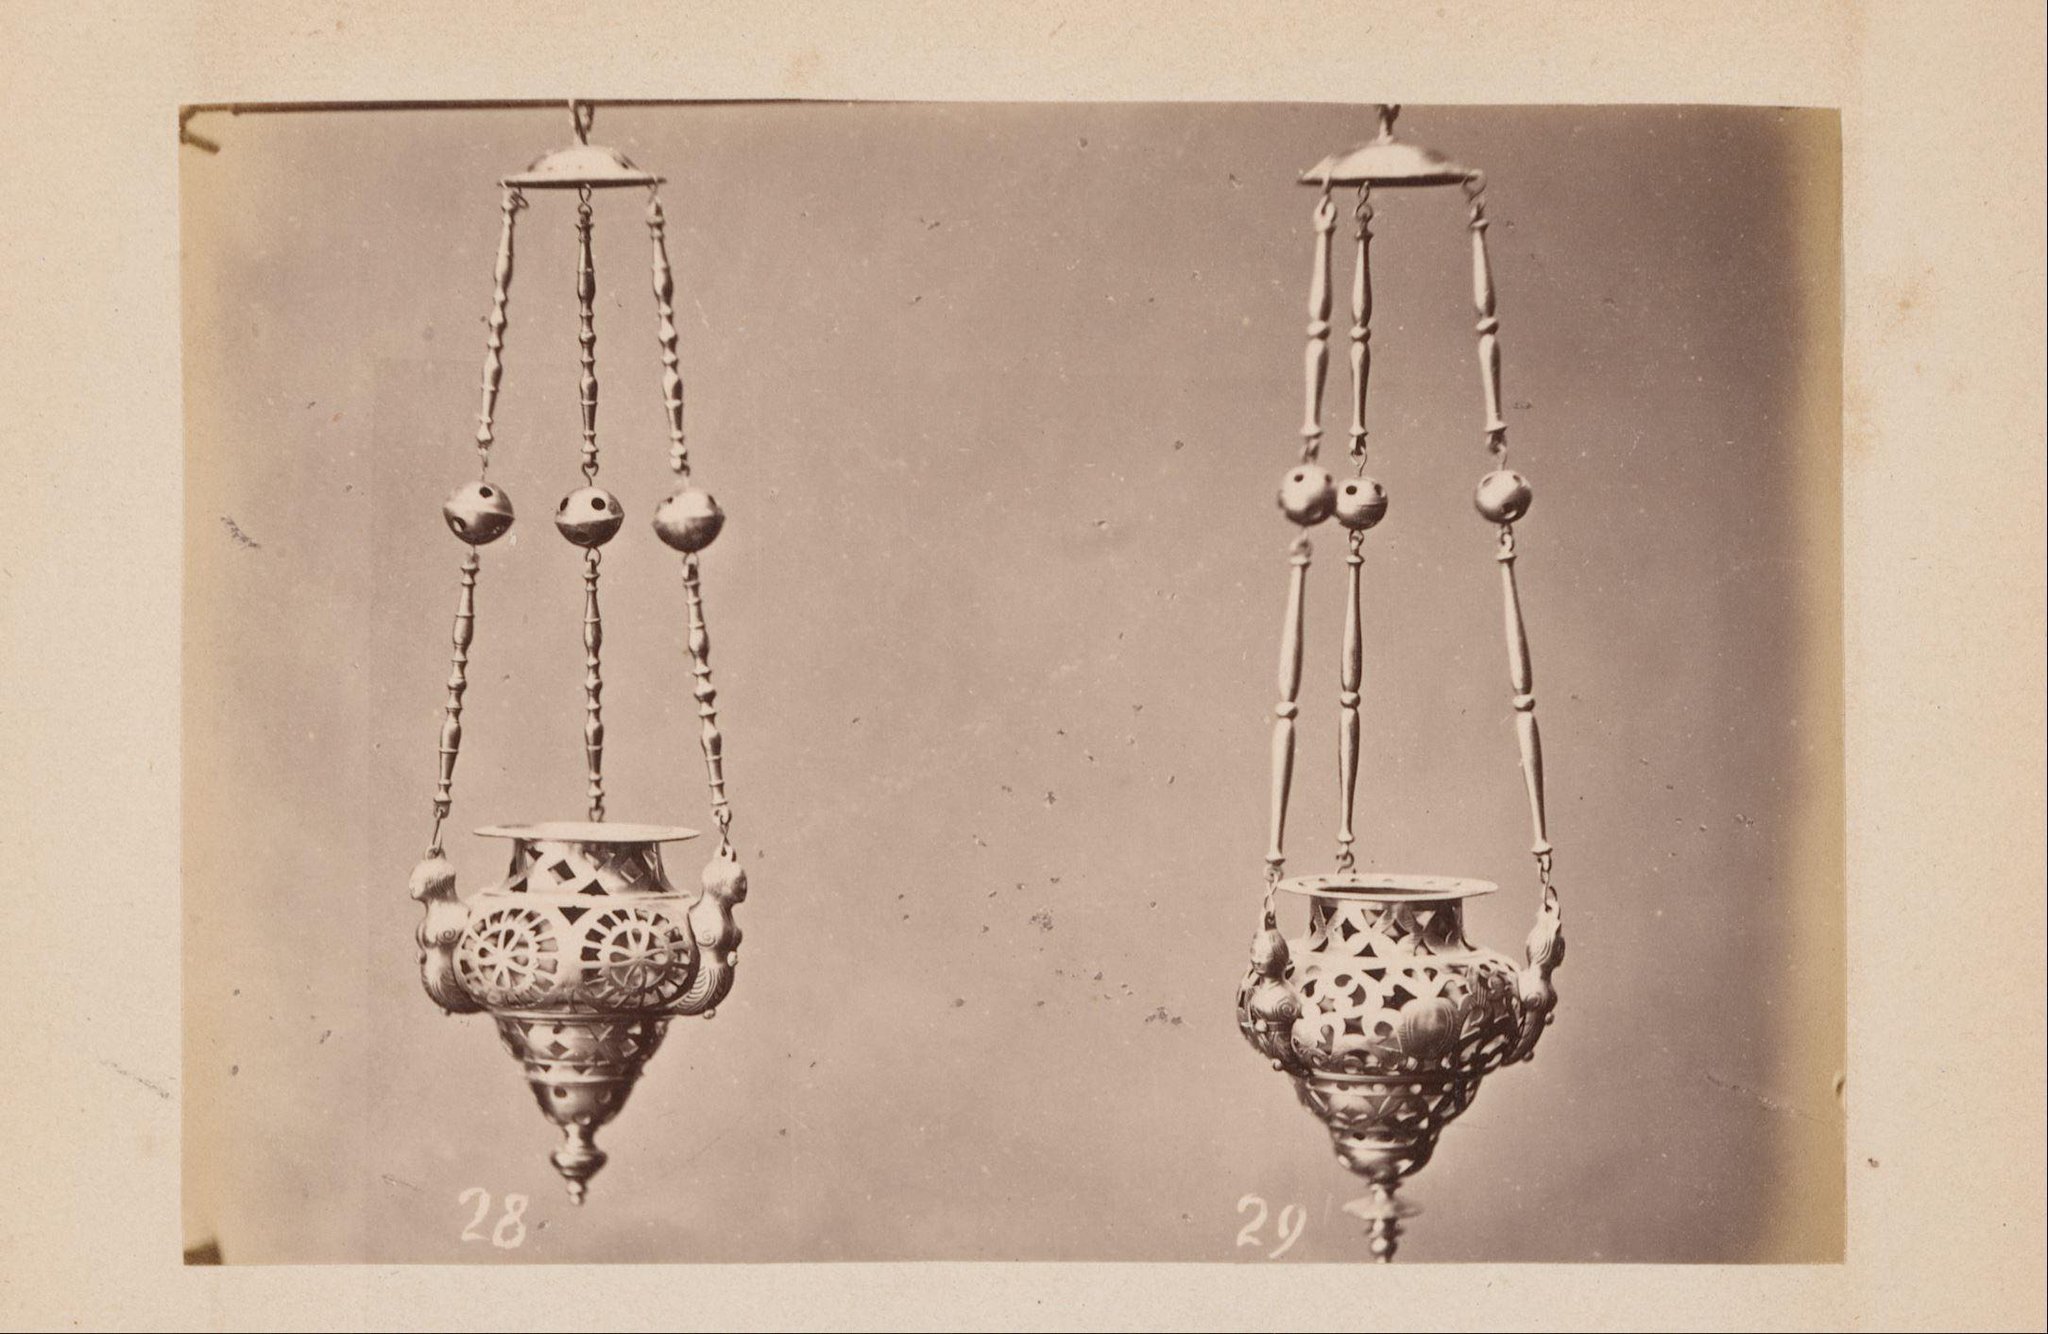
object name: photograph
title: Metalen hanglampen in San Marco model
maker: Anonymous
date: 1860-1885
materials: photographic support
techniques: albumen print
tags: lighting; lamps